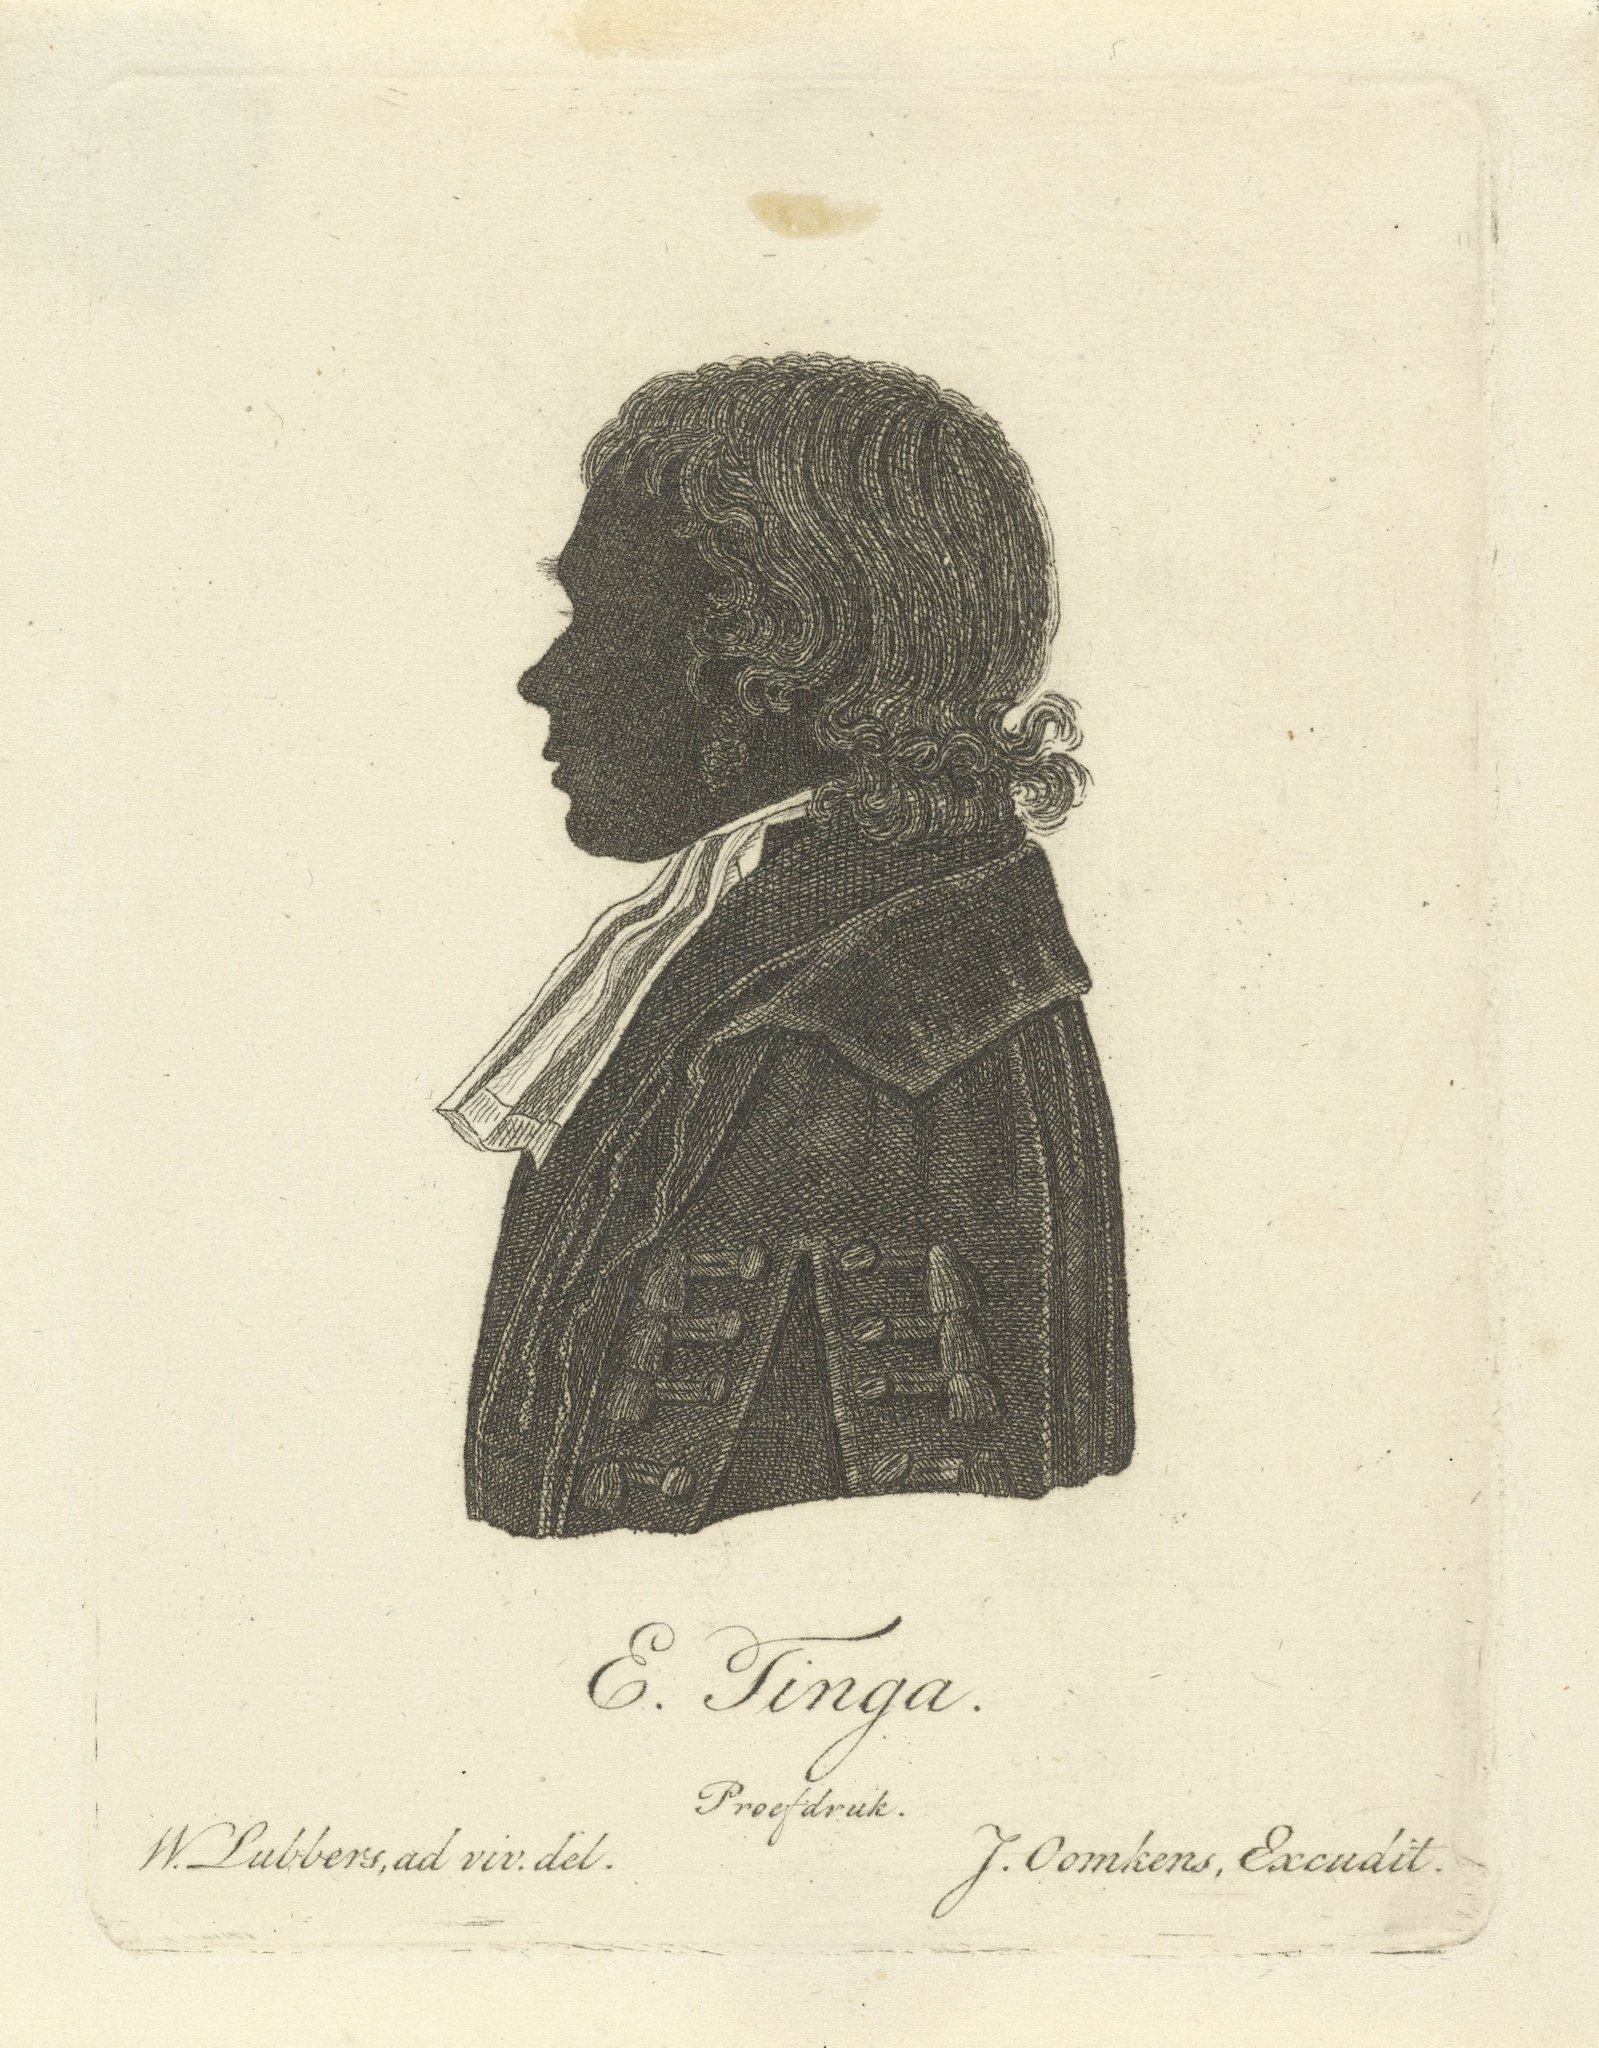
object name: print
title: Silhouetportret van Eelco Tinga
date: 1808-1844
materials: paper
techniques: etching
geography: groningen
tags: leeuwarden, groningen, professor in de theologie, eelco tinga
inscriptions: collector's mark: Lugt 2228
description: Silhouetportret van Eelco Tinga, buste naar links.